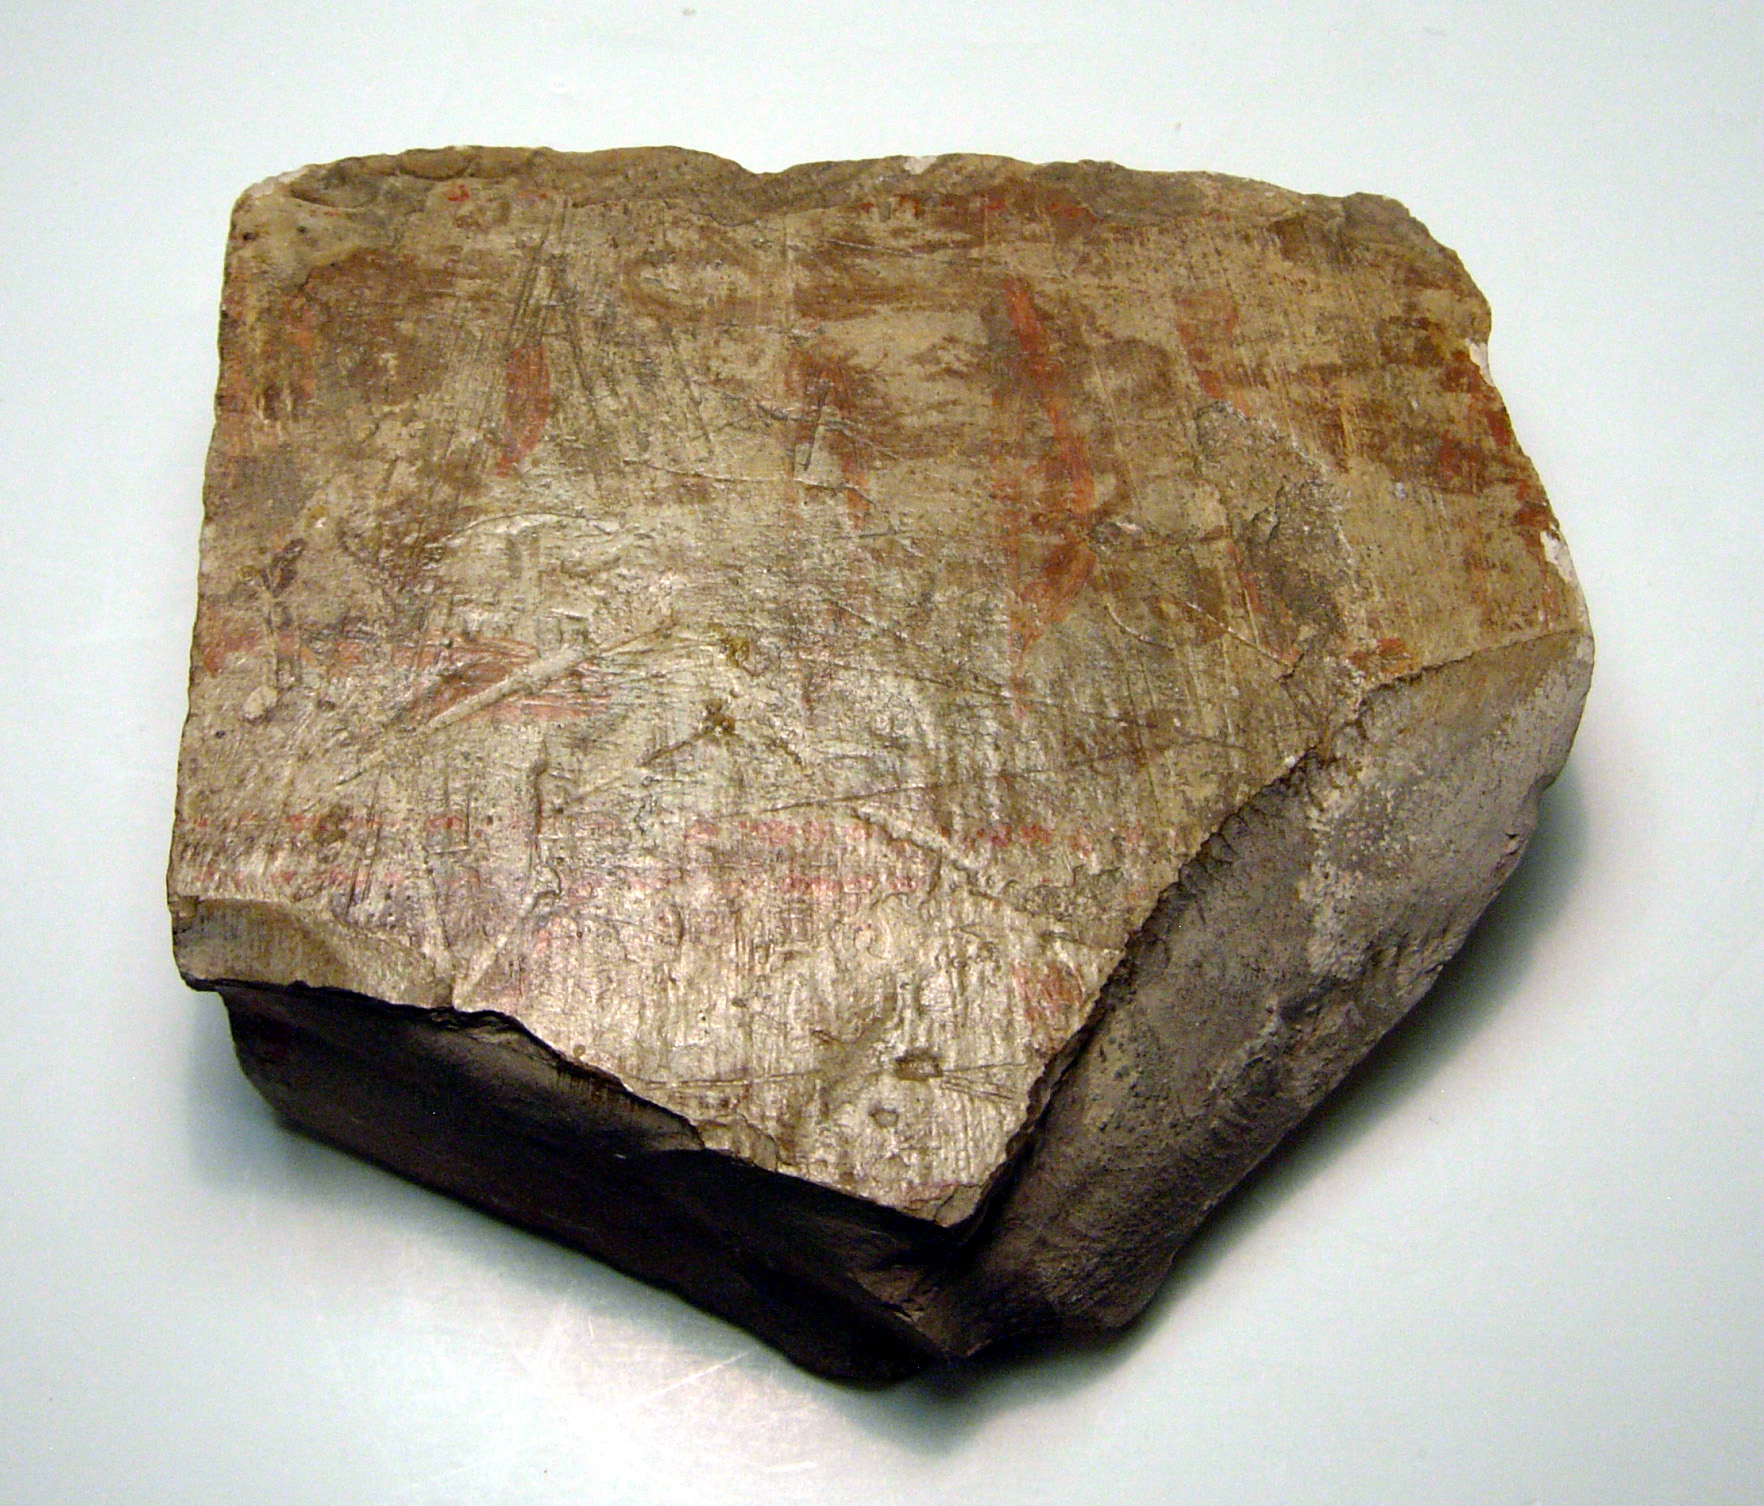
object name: relief, tomb of nespekashuty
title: Drawing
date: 664-610 BCE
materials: limestone, mortar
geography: egypt